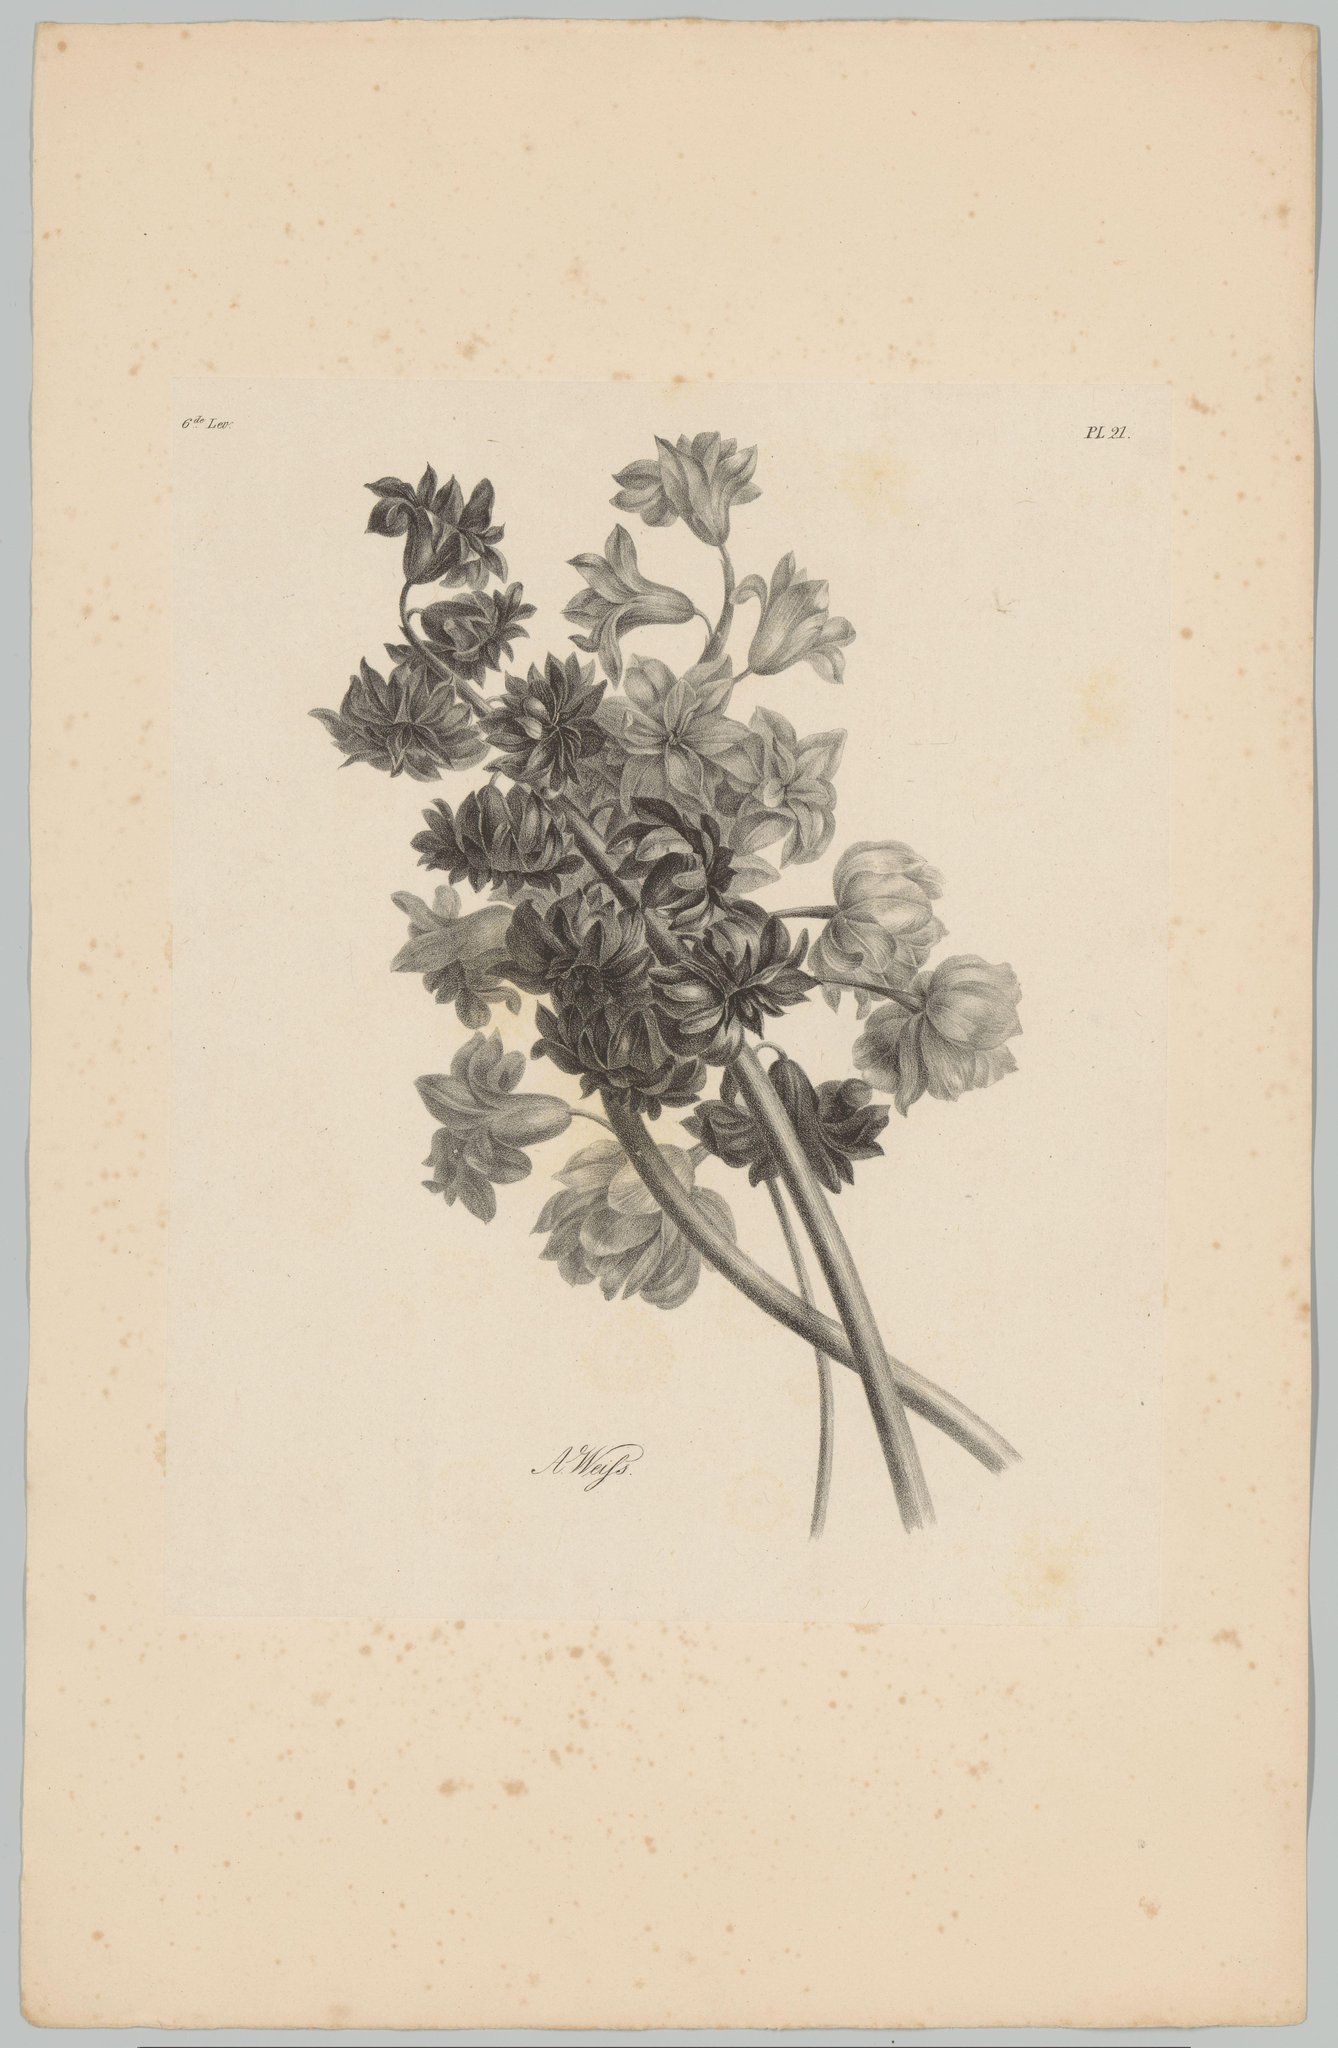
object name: print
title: Bloemen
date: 1820-1833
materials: paper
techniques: lithograph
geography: amsterdam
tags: flowers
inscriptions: collector's mark: Lugt 2228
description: Links boven genummerd 6de Lev. Onderdeel van een omslag met in totaal zevenenzeventig lithografieën van bloemen en fruit.